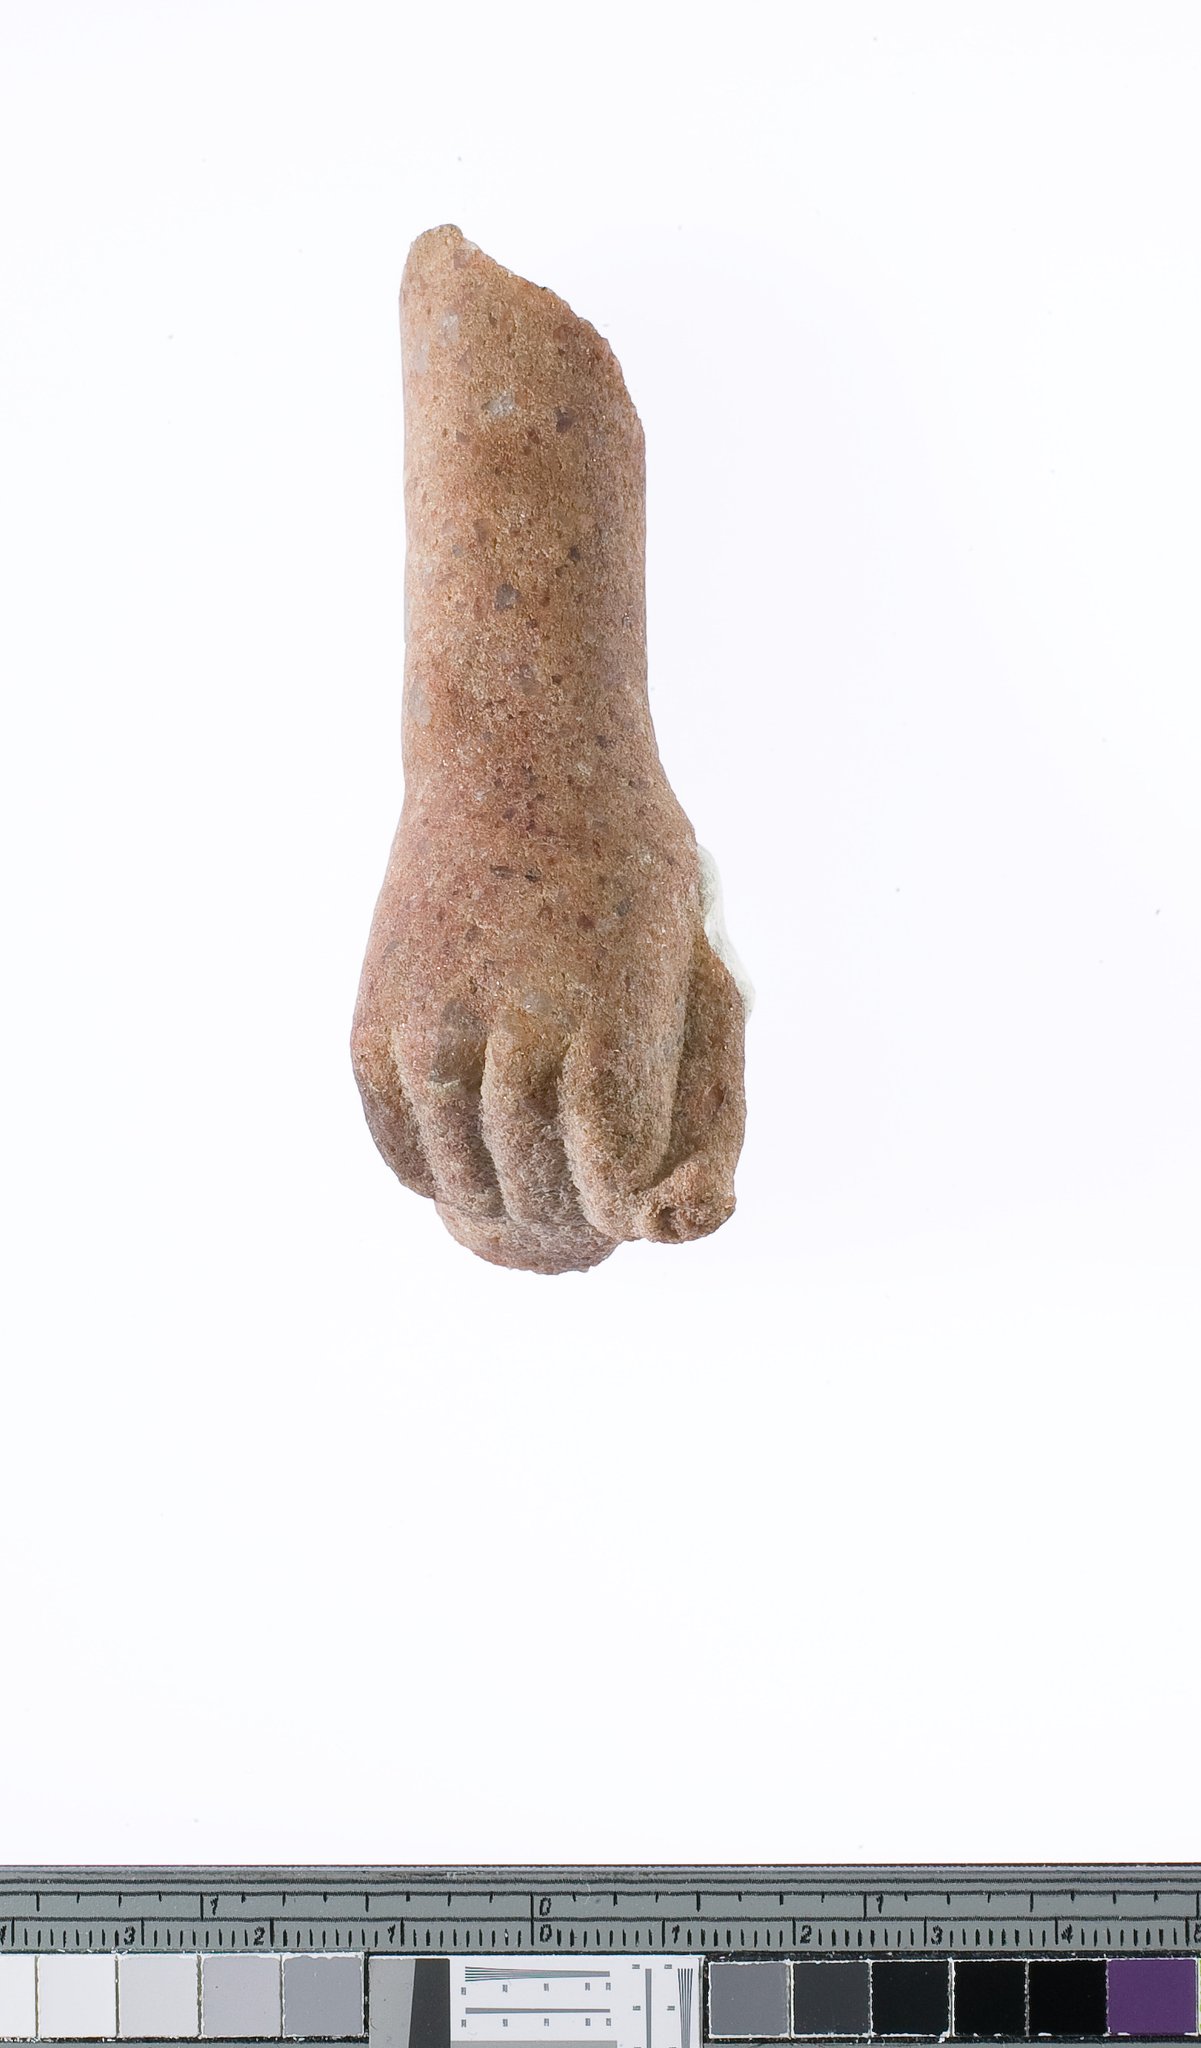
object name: hand, right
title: Right Hand of a Statuette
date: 1353-1336 BCE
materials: quartzite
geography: egypt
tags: hands